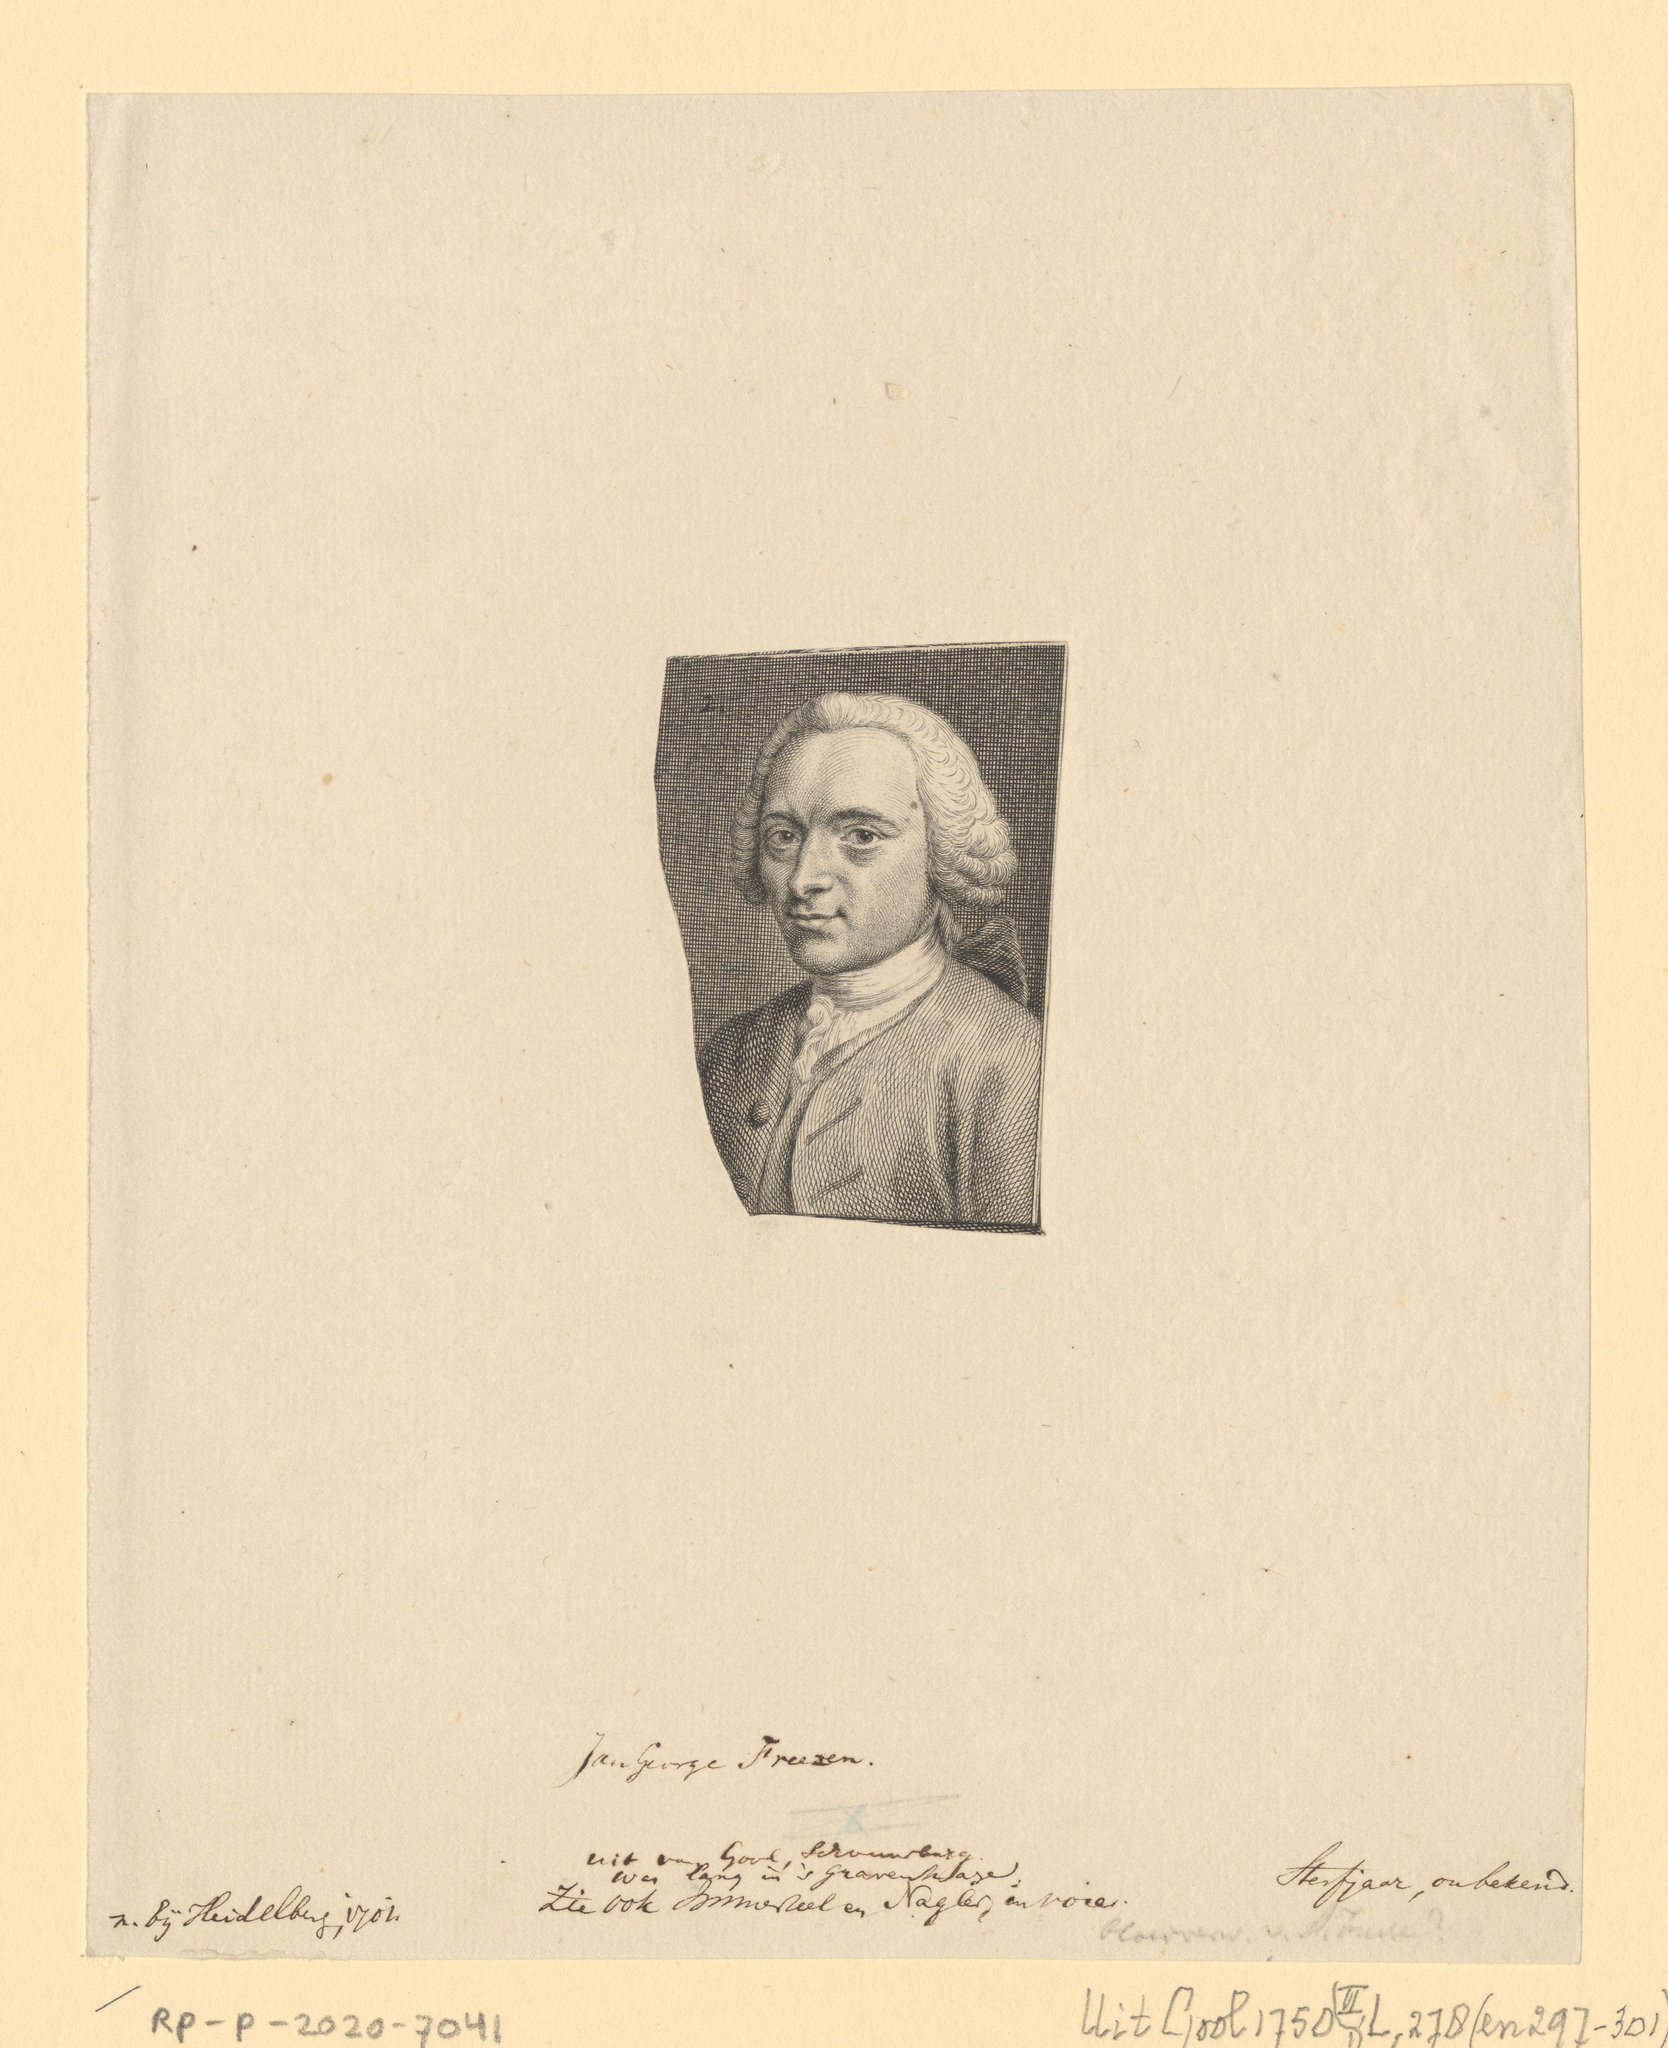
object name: print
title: Portret van Jan George Freezen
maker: pieter tanjé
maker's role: draughtsman, print maker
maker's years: 1706-1761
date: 1751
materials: paper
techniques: engraving, etching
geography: amsterdam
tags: painter, historical persons, portrait, self-portrait of painter, wig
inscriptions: inscription: ‘Jan George Freezen./ uit van Gool, schouwburg/ was lang in 's Gravenhage (...)’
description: Prent waarschijnlijk uit: Gool, Johan van. De nieuwe schouburg der Nederlantsche kunstschilders en schilderessen (...). Den Haag: Johan van Gool, 1751, dl. 2, p. 278.